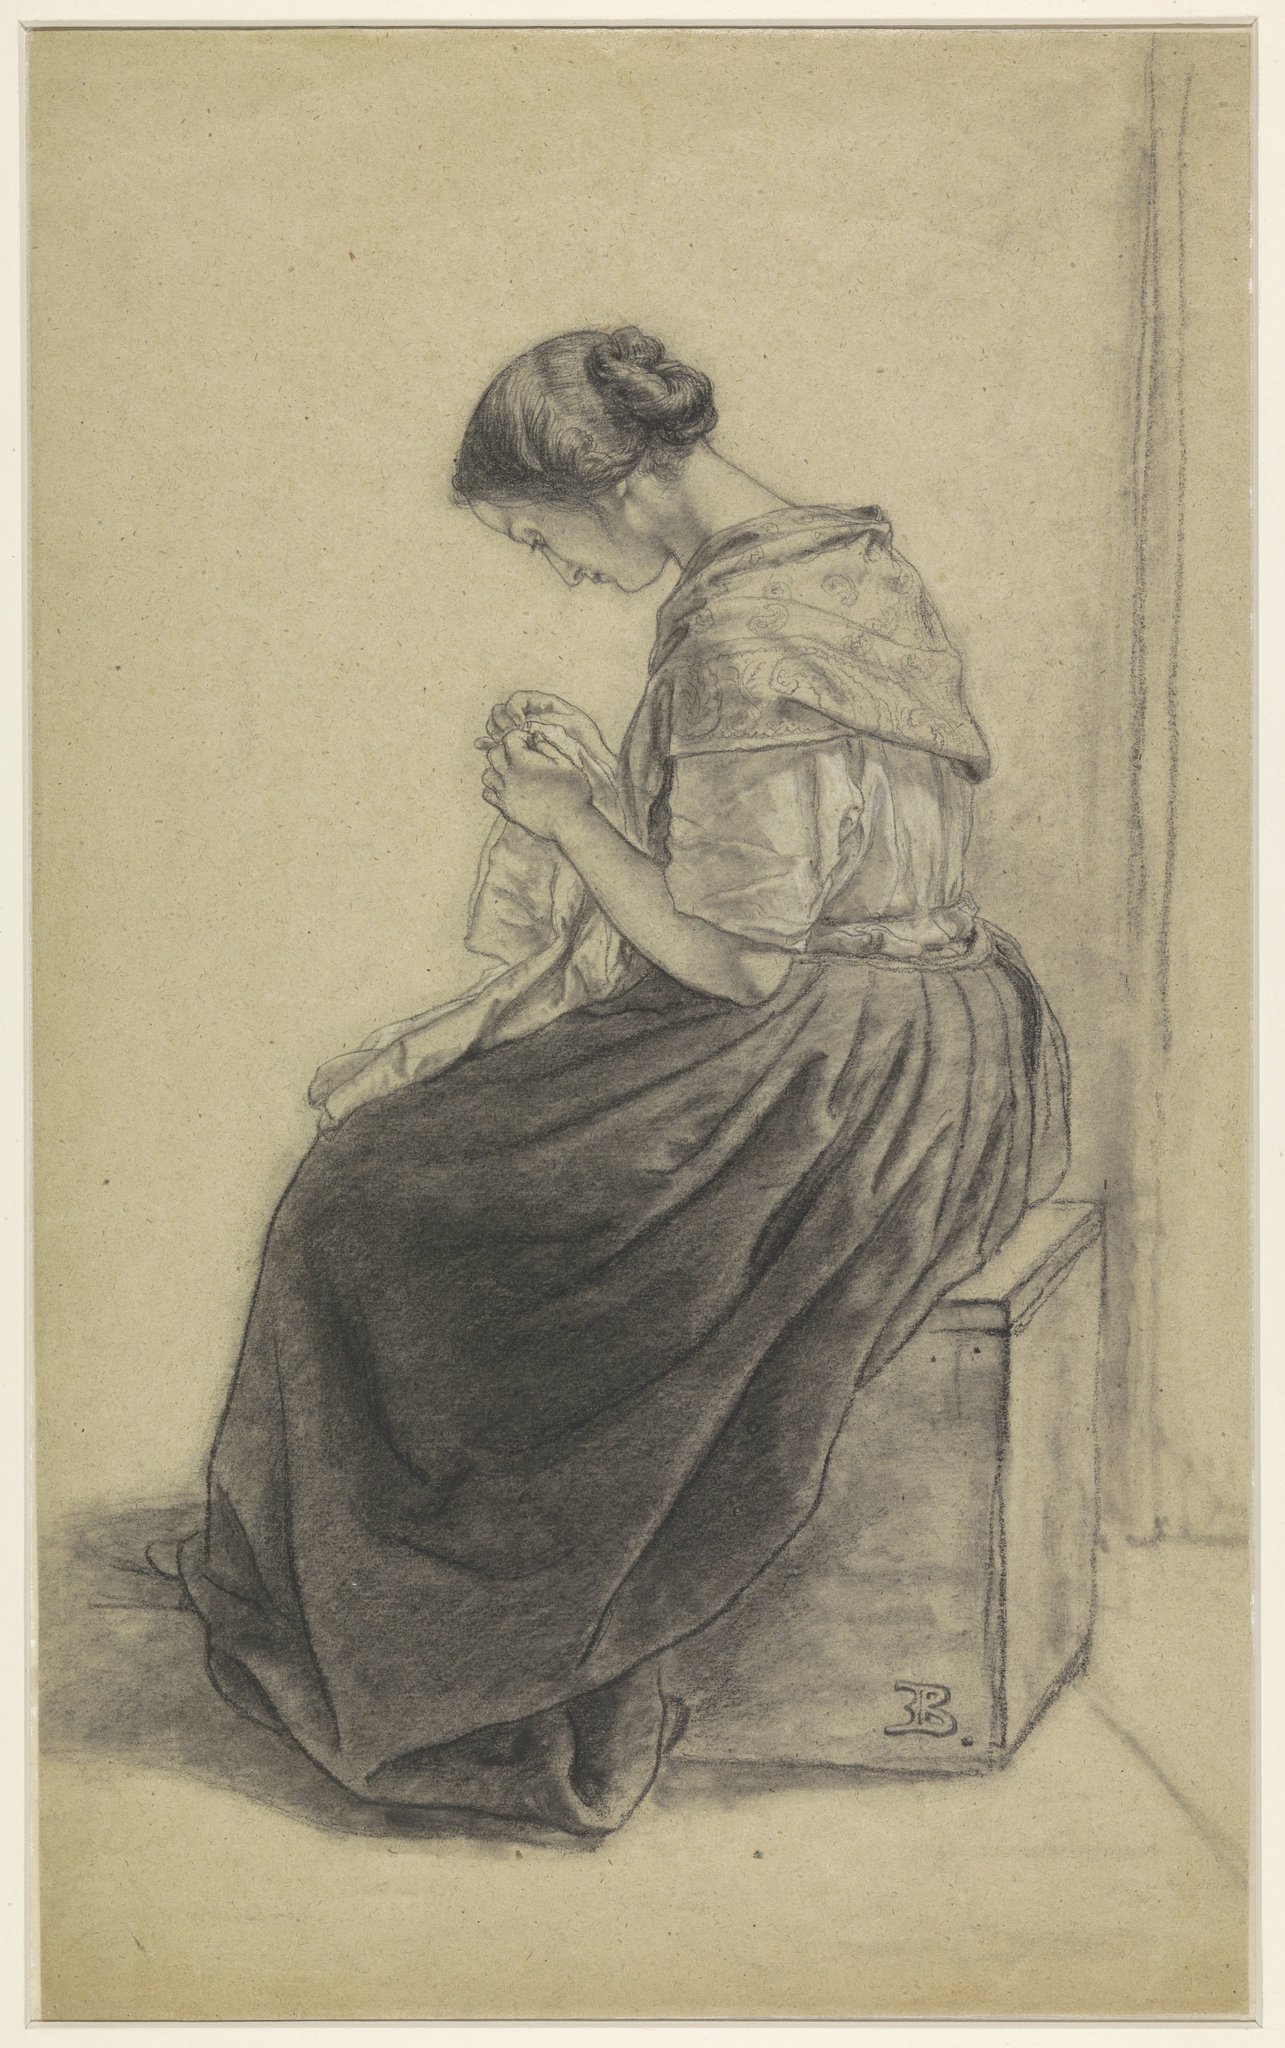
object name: drawing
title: Zittende handwerkende vrouw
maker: eugène françois de block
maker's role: draughtsman, painter, print maker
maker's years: 1812-1893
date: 1822-1893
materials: chalk, paper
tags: sitting figure - aa - female human figure, home sewing; repair of clothes